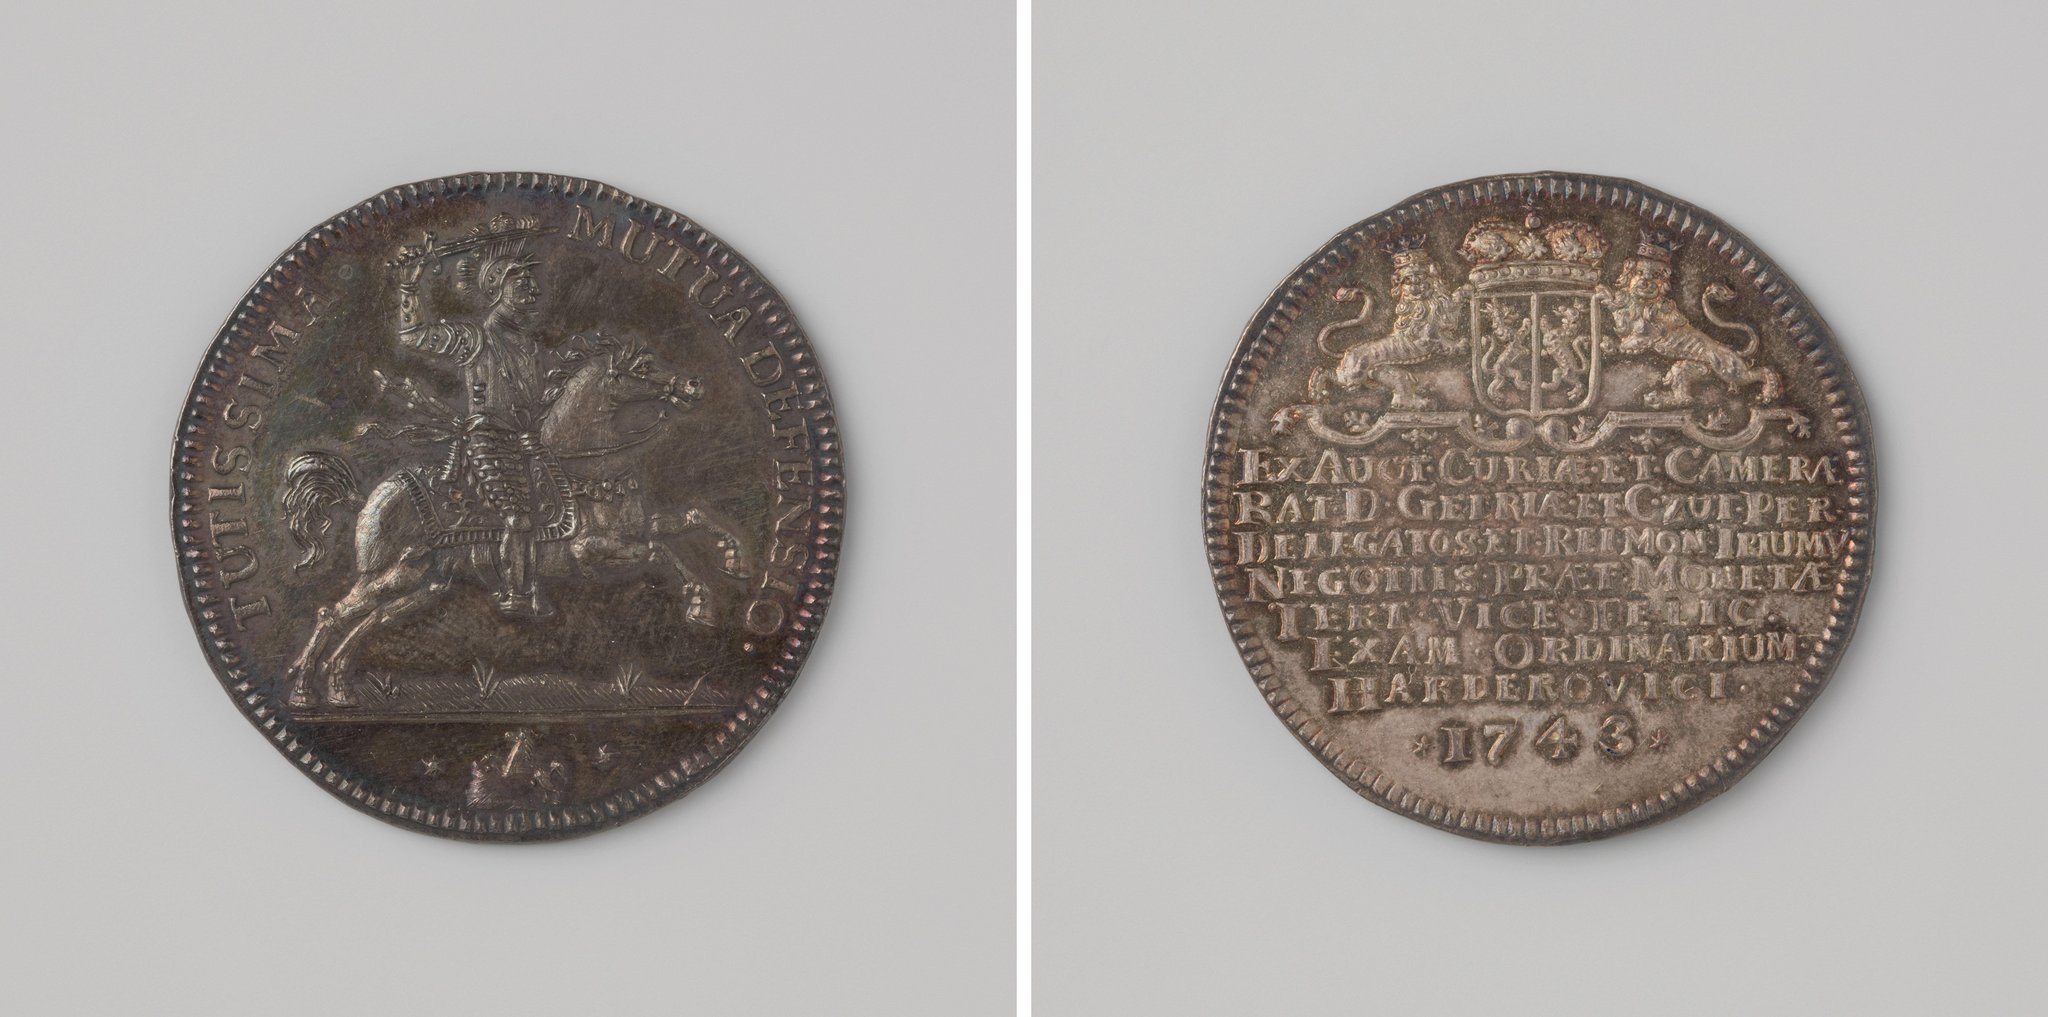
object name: history medal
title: Voor de derde maal de munt te Harderwijk geinspecteerd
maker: Anonymous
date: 1743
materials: silver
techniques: striking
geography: harderwijk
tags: harderwijk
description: Zilveren penning. Voorzijde: ruiter met zwaard in hand binnen omschrift (stempel van dukaton); onder afbeelding: steigerend paard (merkteken van munt van Harderwijk). Keerzijde: opschrift onder gekroond wapenschild van Gelderland, geflankeerd door twee gekroonde leeuwen